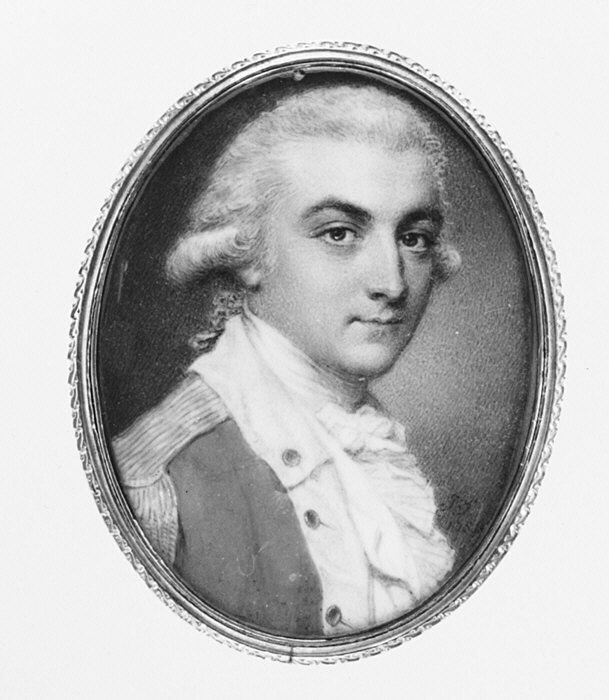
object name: painting, miniature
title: Portrait of an Officer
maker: john smart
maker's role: artist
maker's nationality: british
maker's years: 1741-1811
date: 1784-1789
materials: ivory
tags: men,portraits